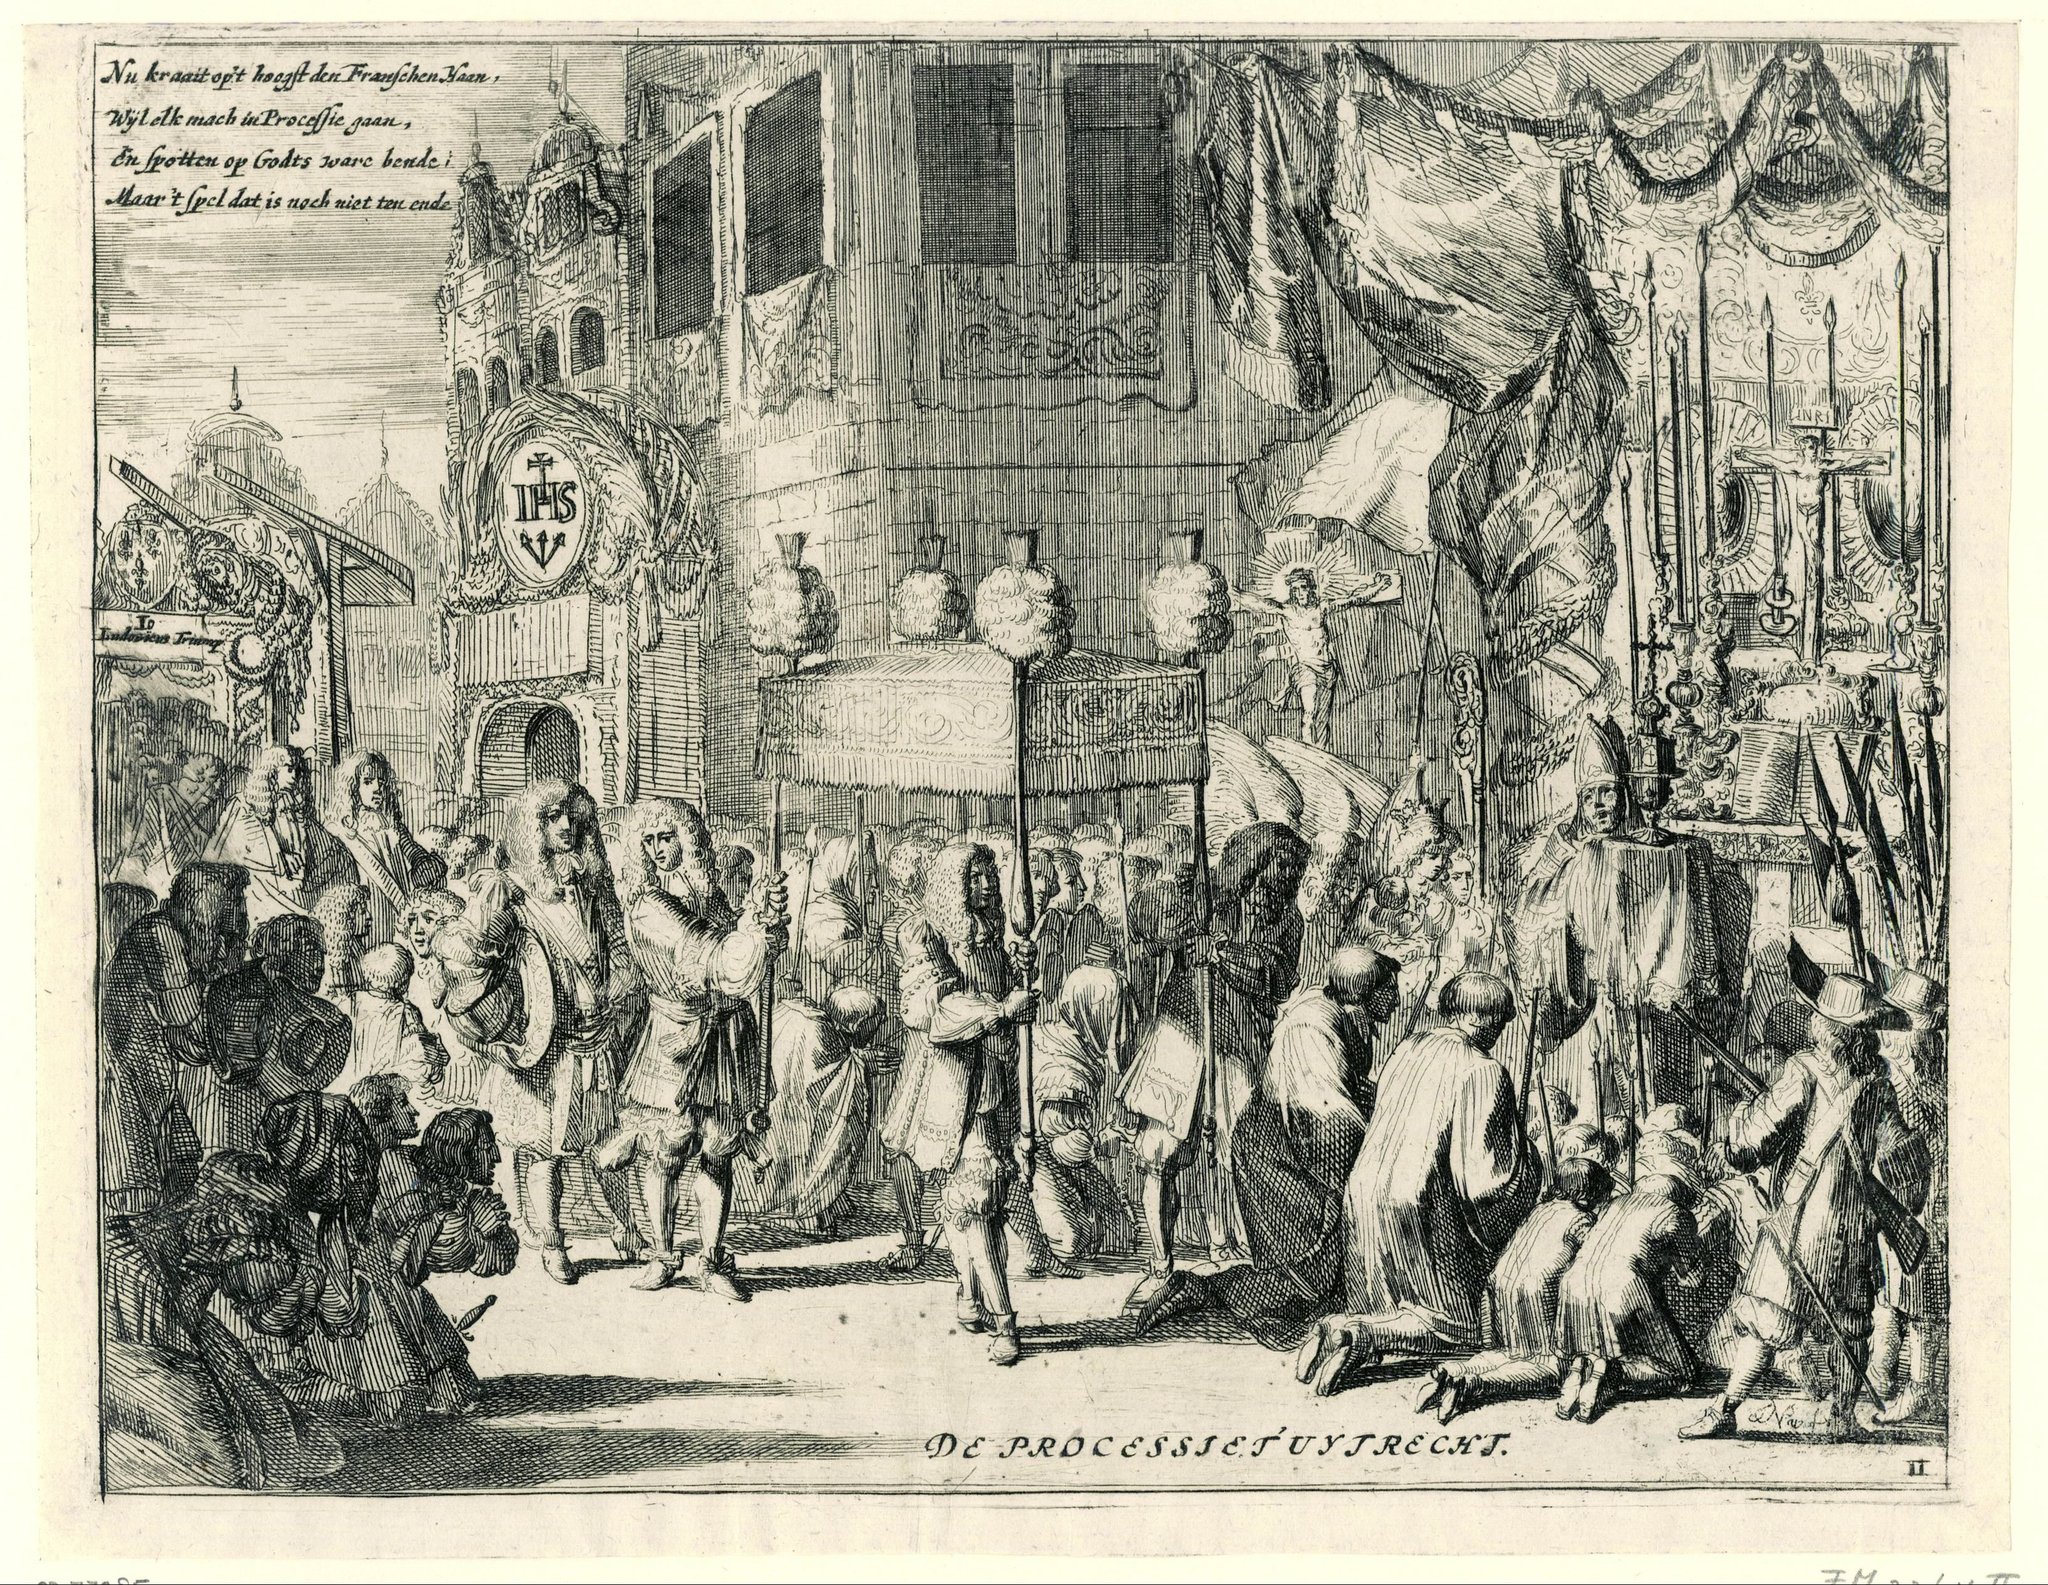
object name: print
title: De Processie t'Uytrecht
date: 1674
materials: paper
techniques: engraving, etching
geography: northern netherlands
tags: procession ~ christian religion, utrecht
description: De processie gehouden door de Franse katholieken op Sacramentsdag van het jaar 1672. Linksboven een vers van 4 regels in het Nederlands. Tweede prent in een reeks van vijf prenten over de gebeurtenissen voorgevallen in Utrecht over de periode 1672-74.